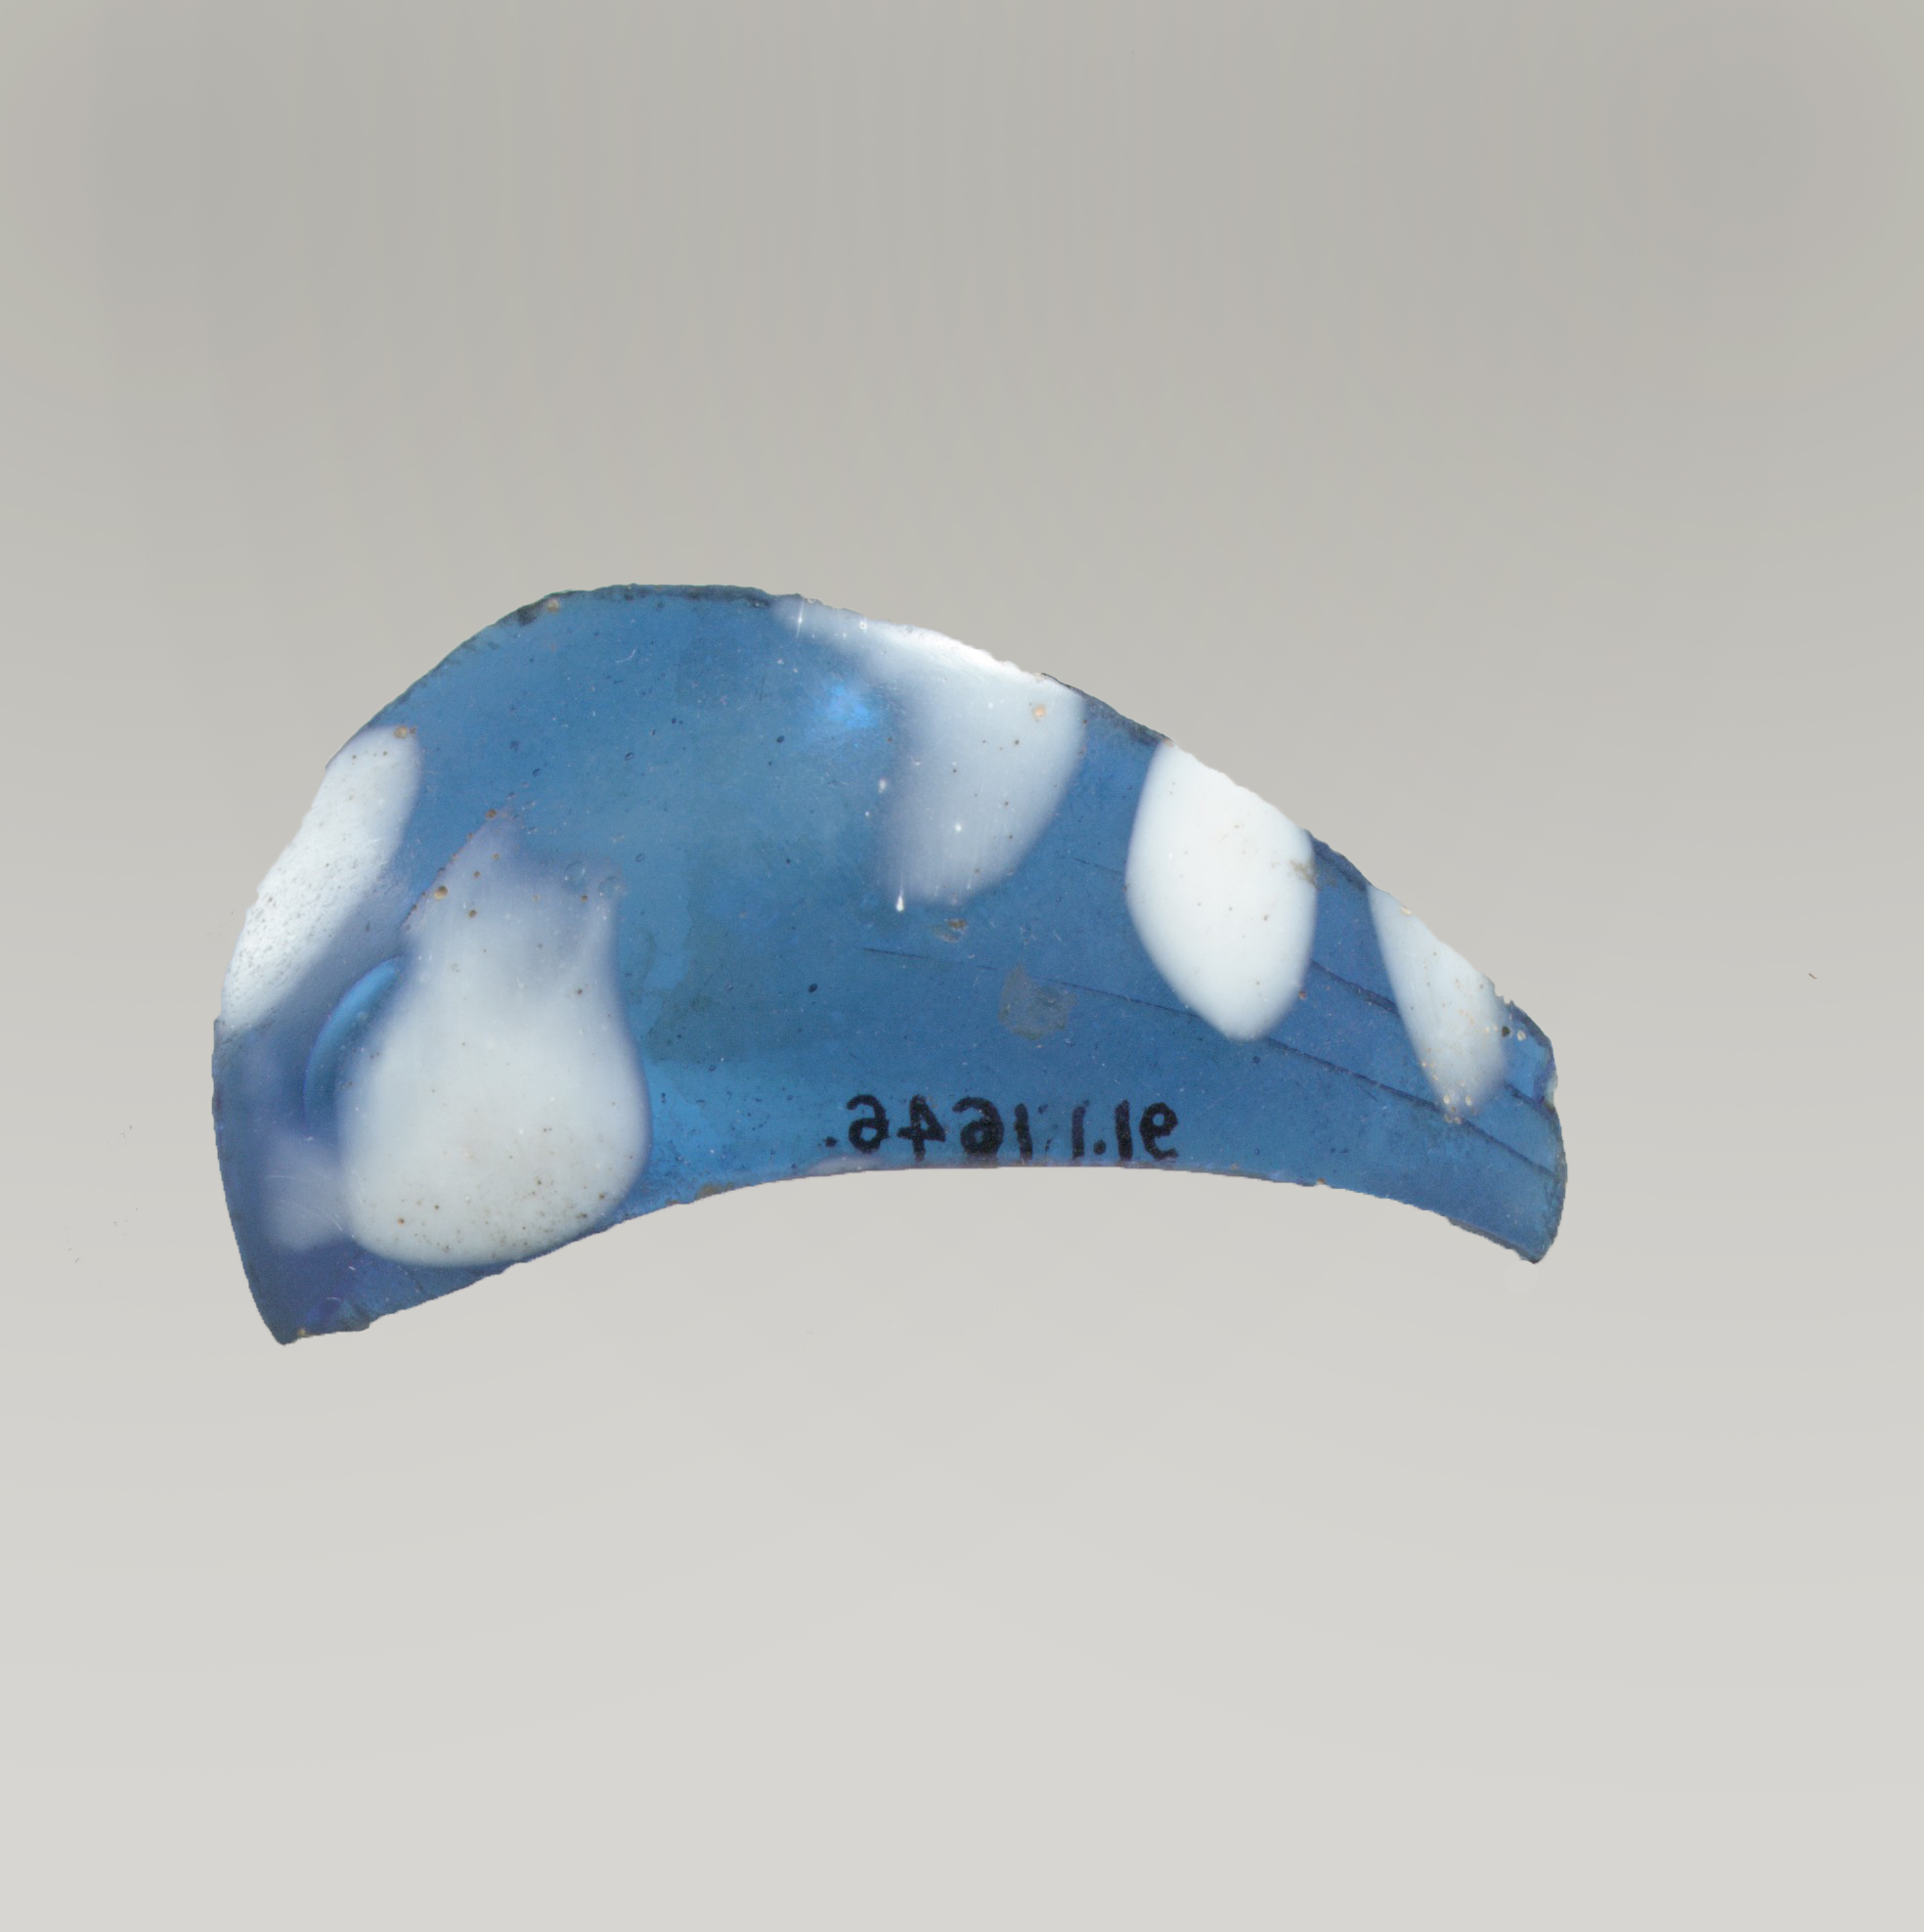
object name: fragment, body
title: Glass fragment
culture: roman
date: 1-100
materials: glass